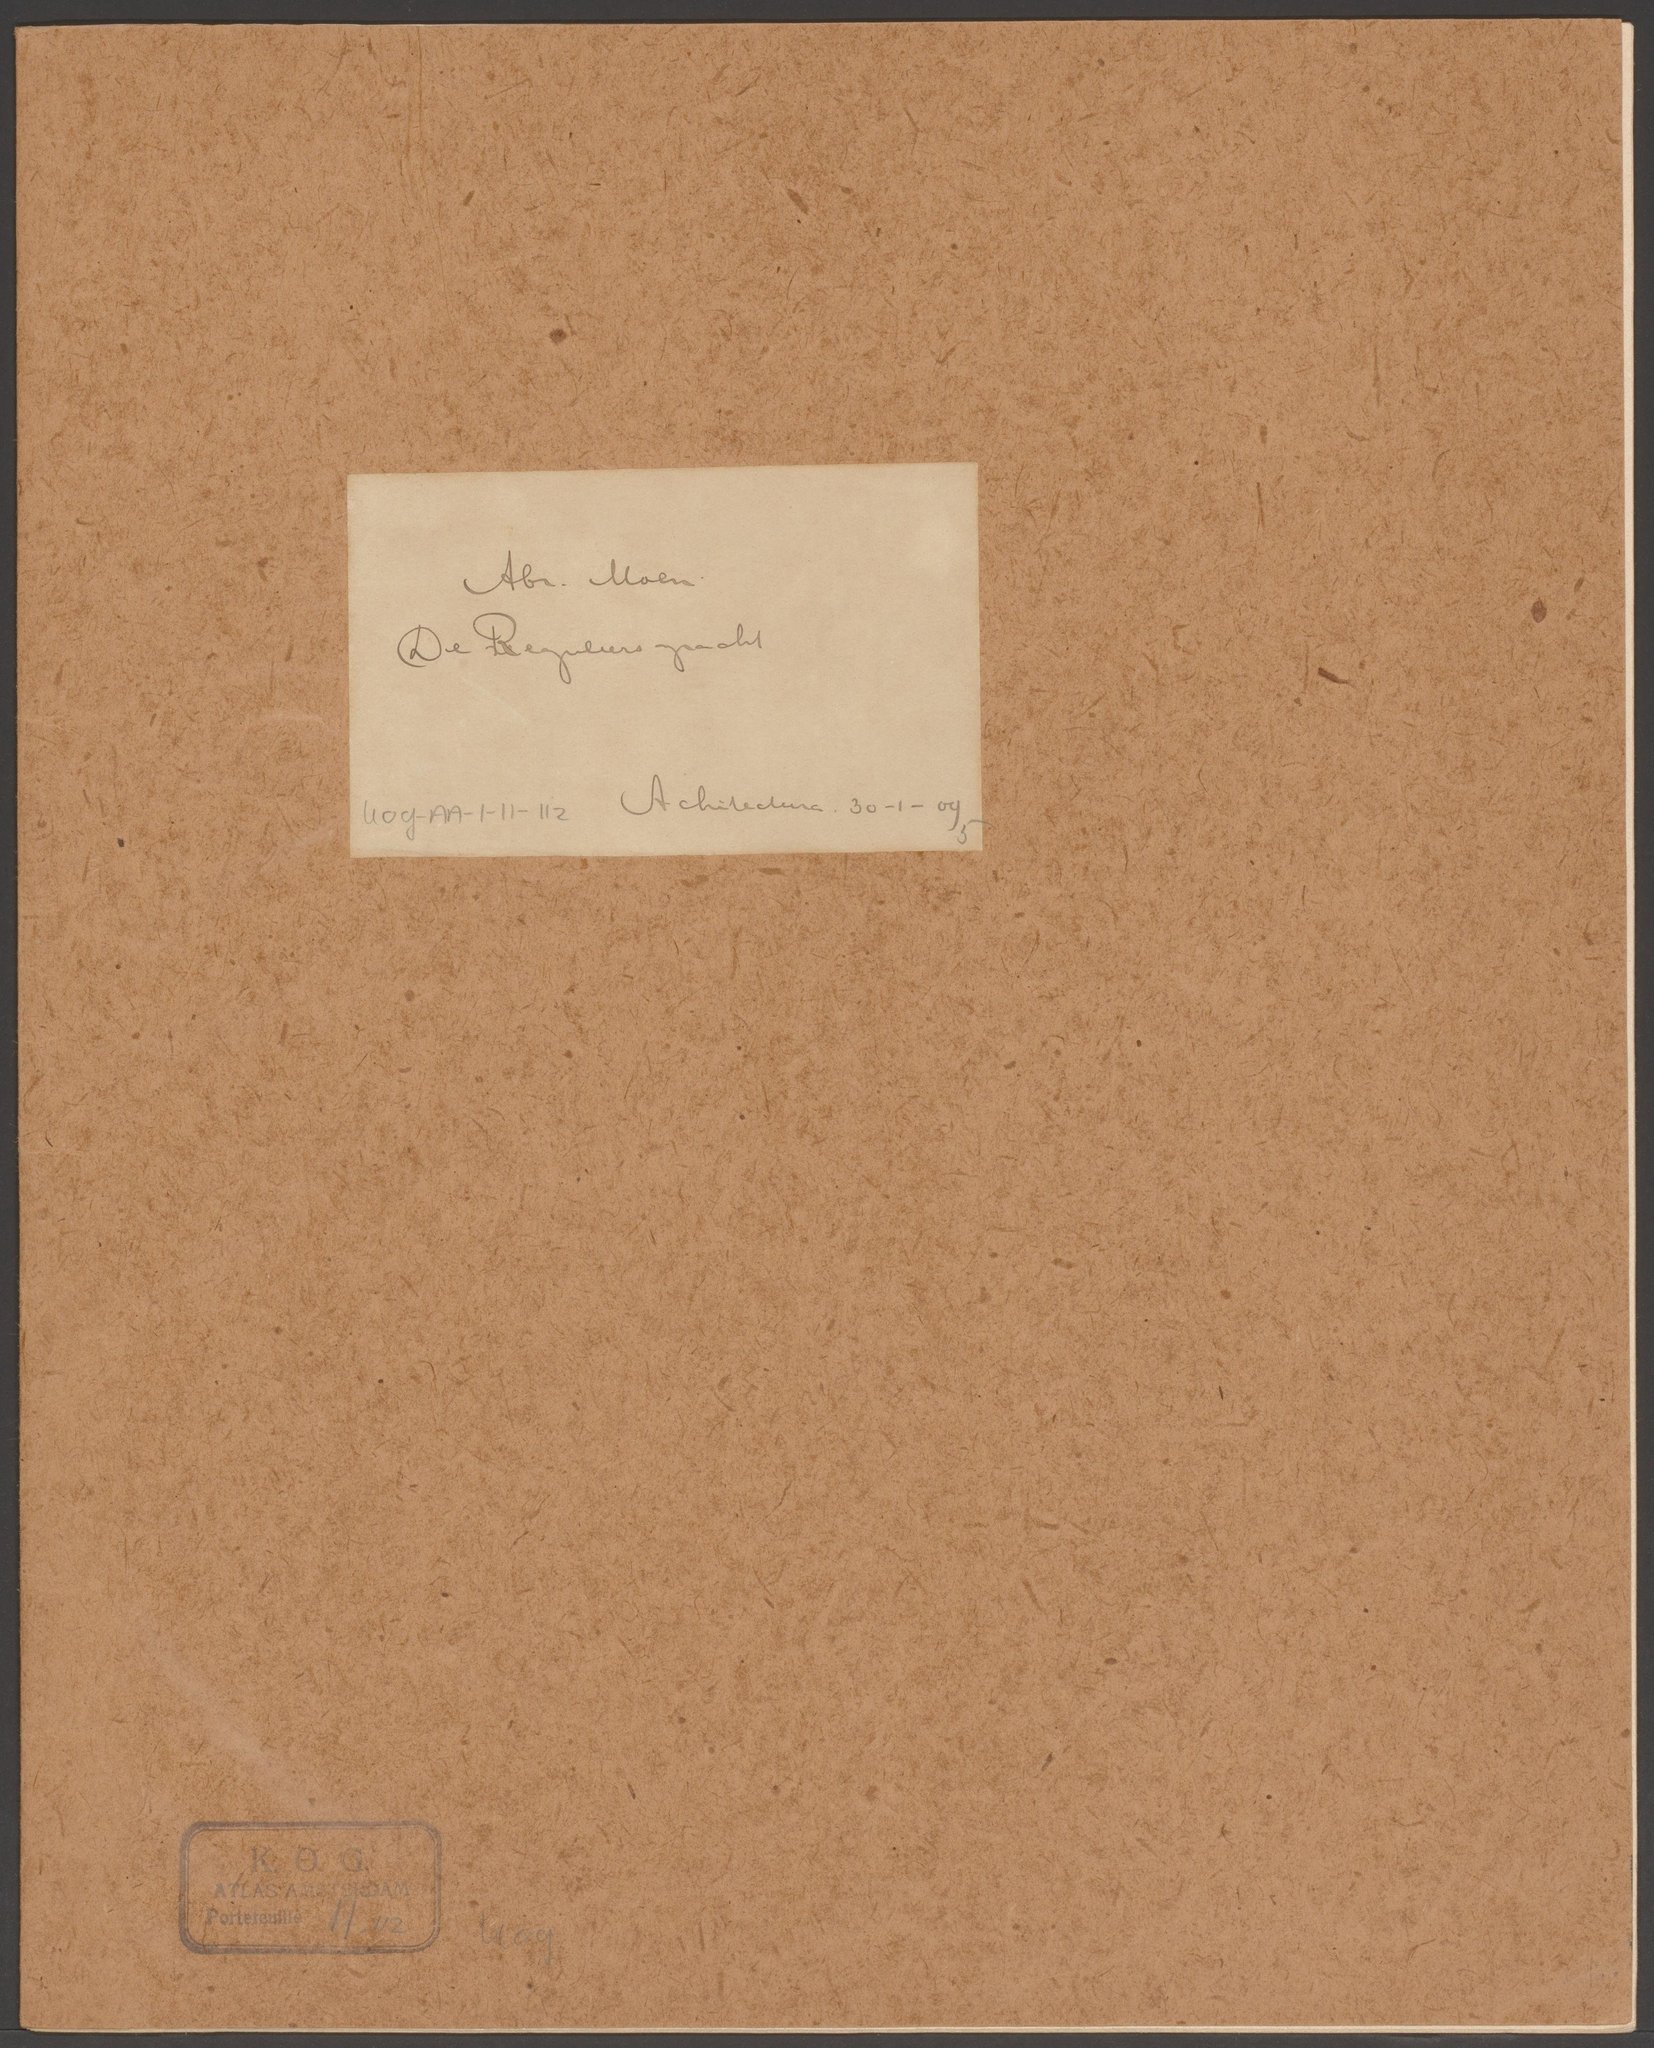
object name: ansichtkaart, prentbriefkaart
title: Bladzijden uit Architectura over de Reguliersgracht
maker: Anonymous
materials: paper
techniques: letterpress printing, line block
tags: city-view in general; 'veduta', canal, building-site, bridge in city across river, canal, etc., street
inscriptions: collector's mark: ‘11.112’ Lugt 1641b, inscription: ‘Adr. Moen./ De Reguliersgracht / Architectura. 30-01-09 / 5’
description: Onderwerpsrubriek binnen de Atlas Amsterdam: Raadhuisstraat, Raamgracht, Raamplein, Rapenburgerstraat, Reguliersgracht, Reguliersbreestraat. Zeven bladzijden uit meerdere uitgaven van Architectura, allen over de Reguliersgracht.